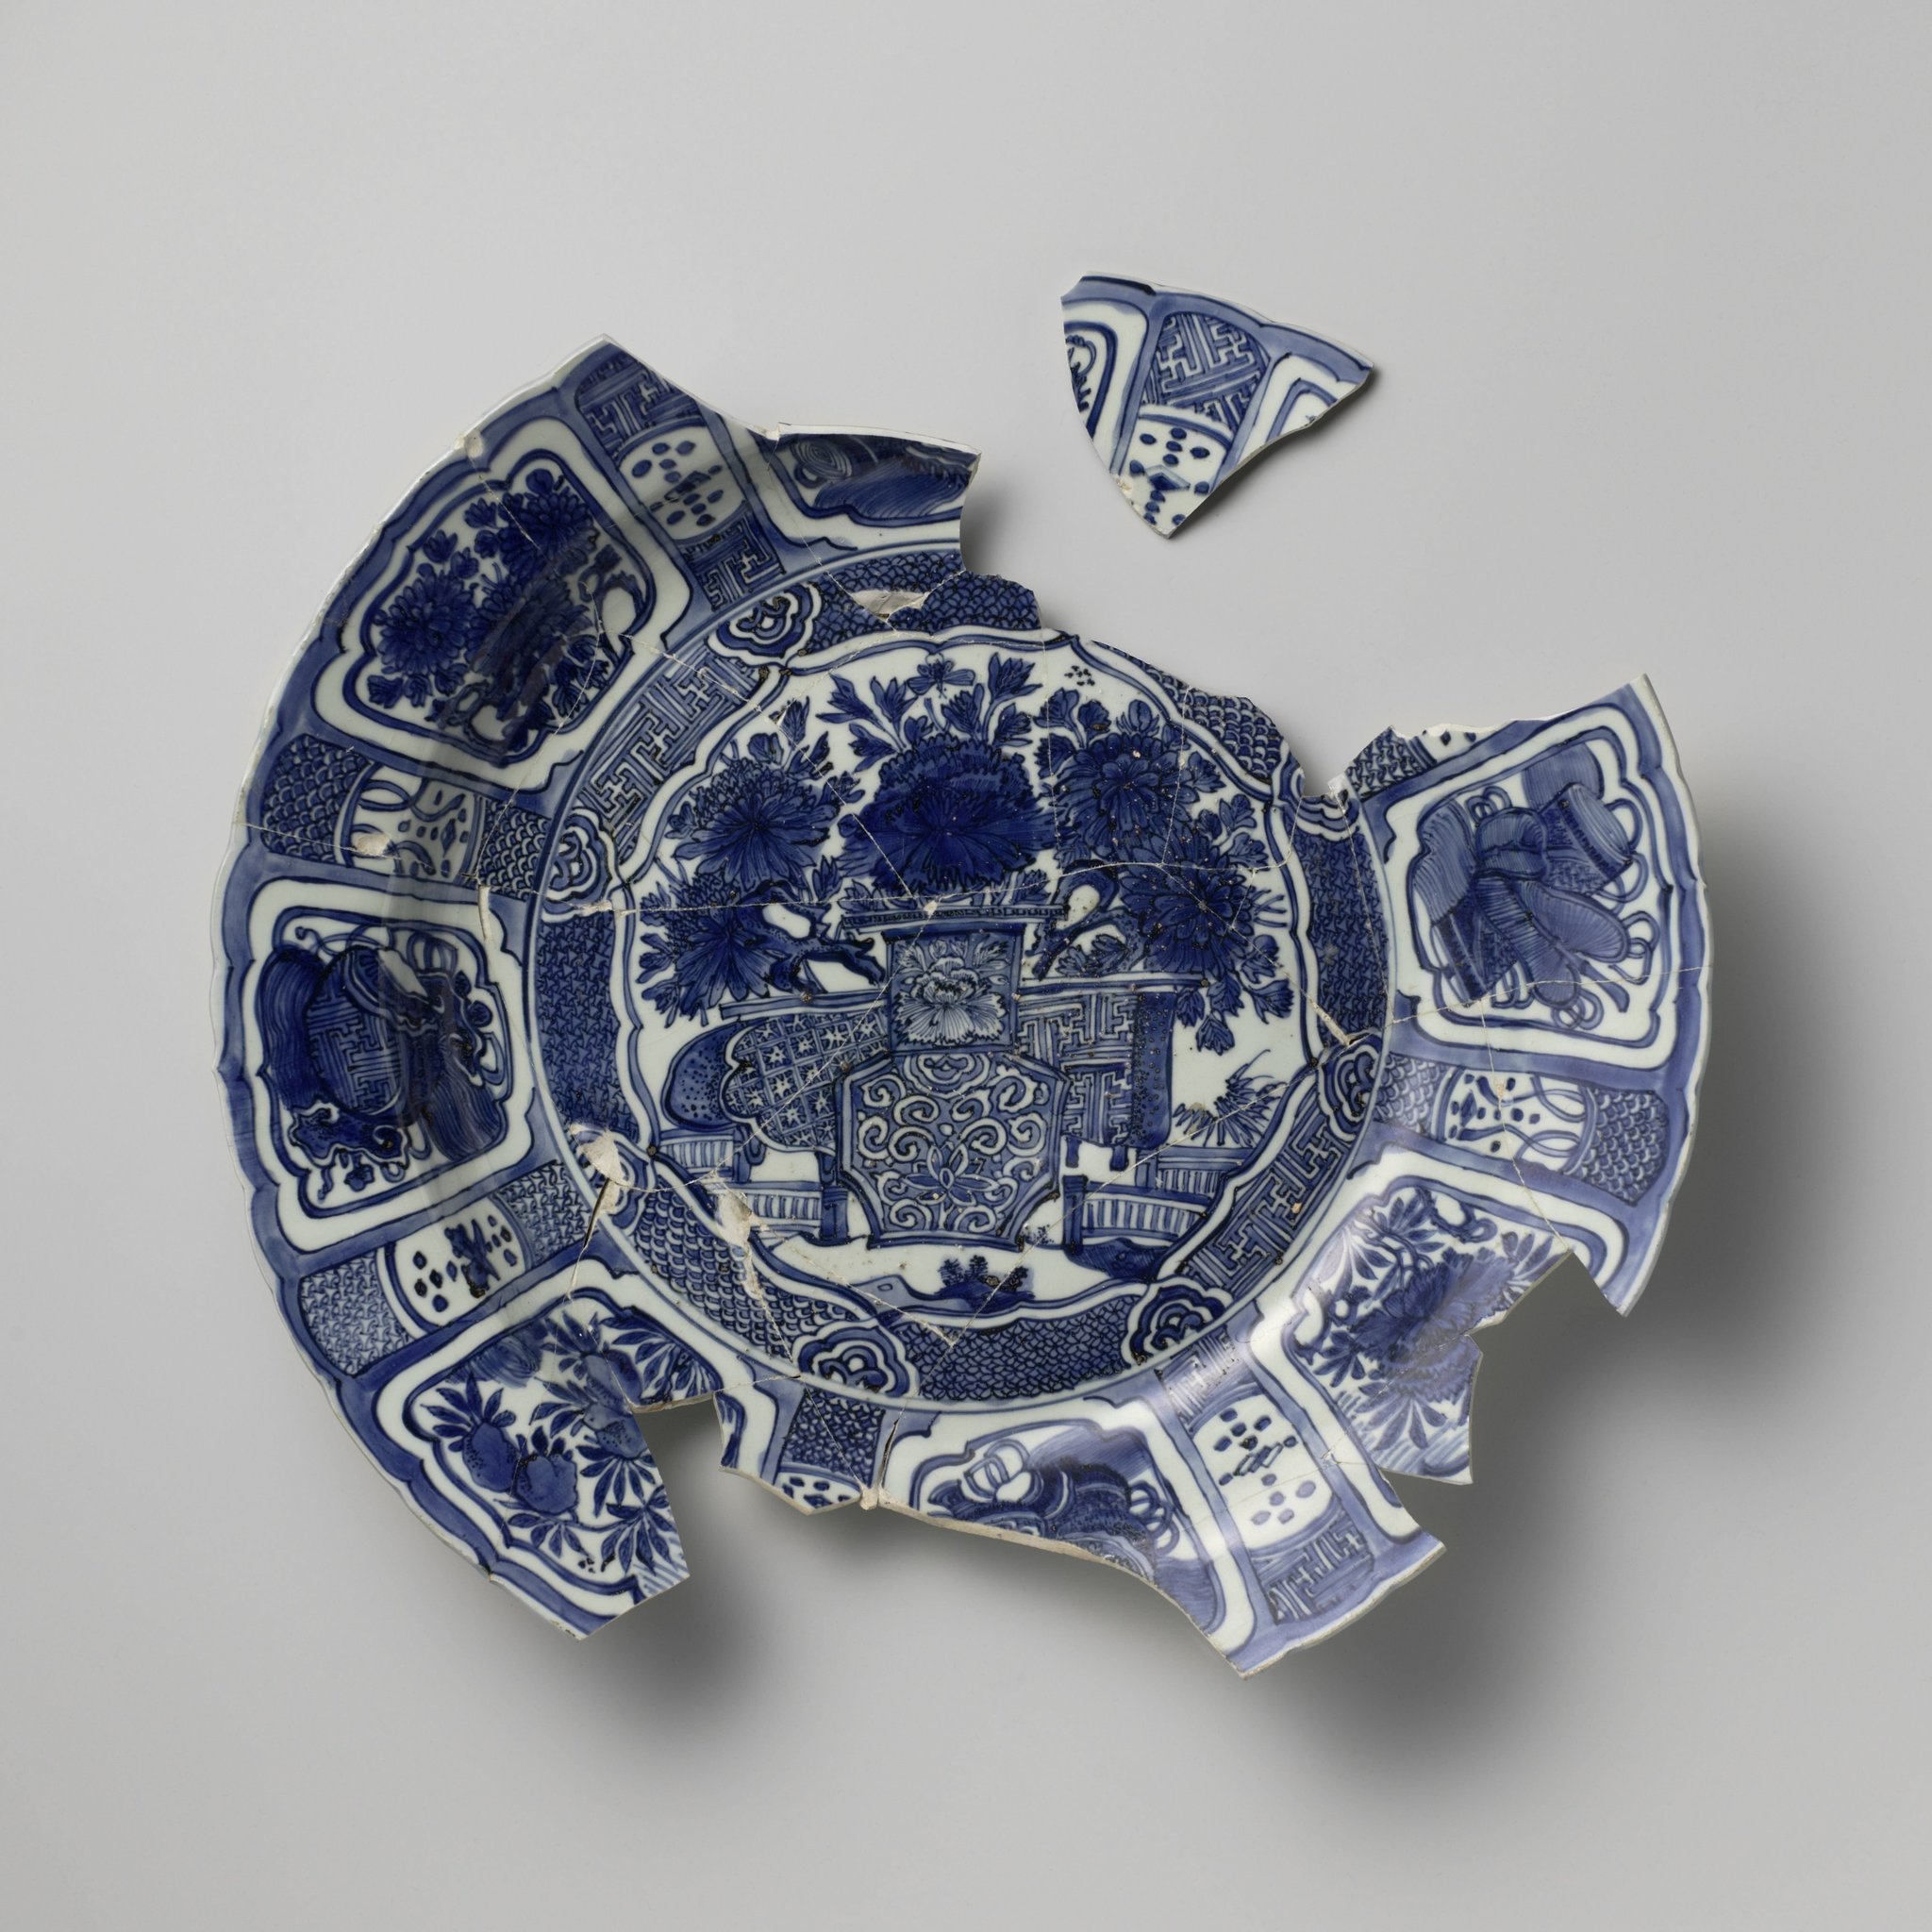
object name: washbowl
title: Fragment en scherf lampetschotel uit V.O.C.-schip de 'Witte Leeuw'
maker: Anonymous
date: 1613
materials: bone china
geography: jingdezhen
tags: verenigde oostindische compagnie, sint-helena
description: Lampetschotel uit V.O.C.-schip de 'Witte Leeuw', 90% aanwezig. De scherf is glasachtig wit. Het glazuur is blauw getint en bladdert over gedeelten van de liprand af. De bodem is ongeglazuurd. De voetring is gefacetteerd en staat naar binnen. Er zijn meer dan 20 korrels ovenzand aangetroffen. De lip is geschulpt.